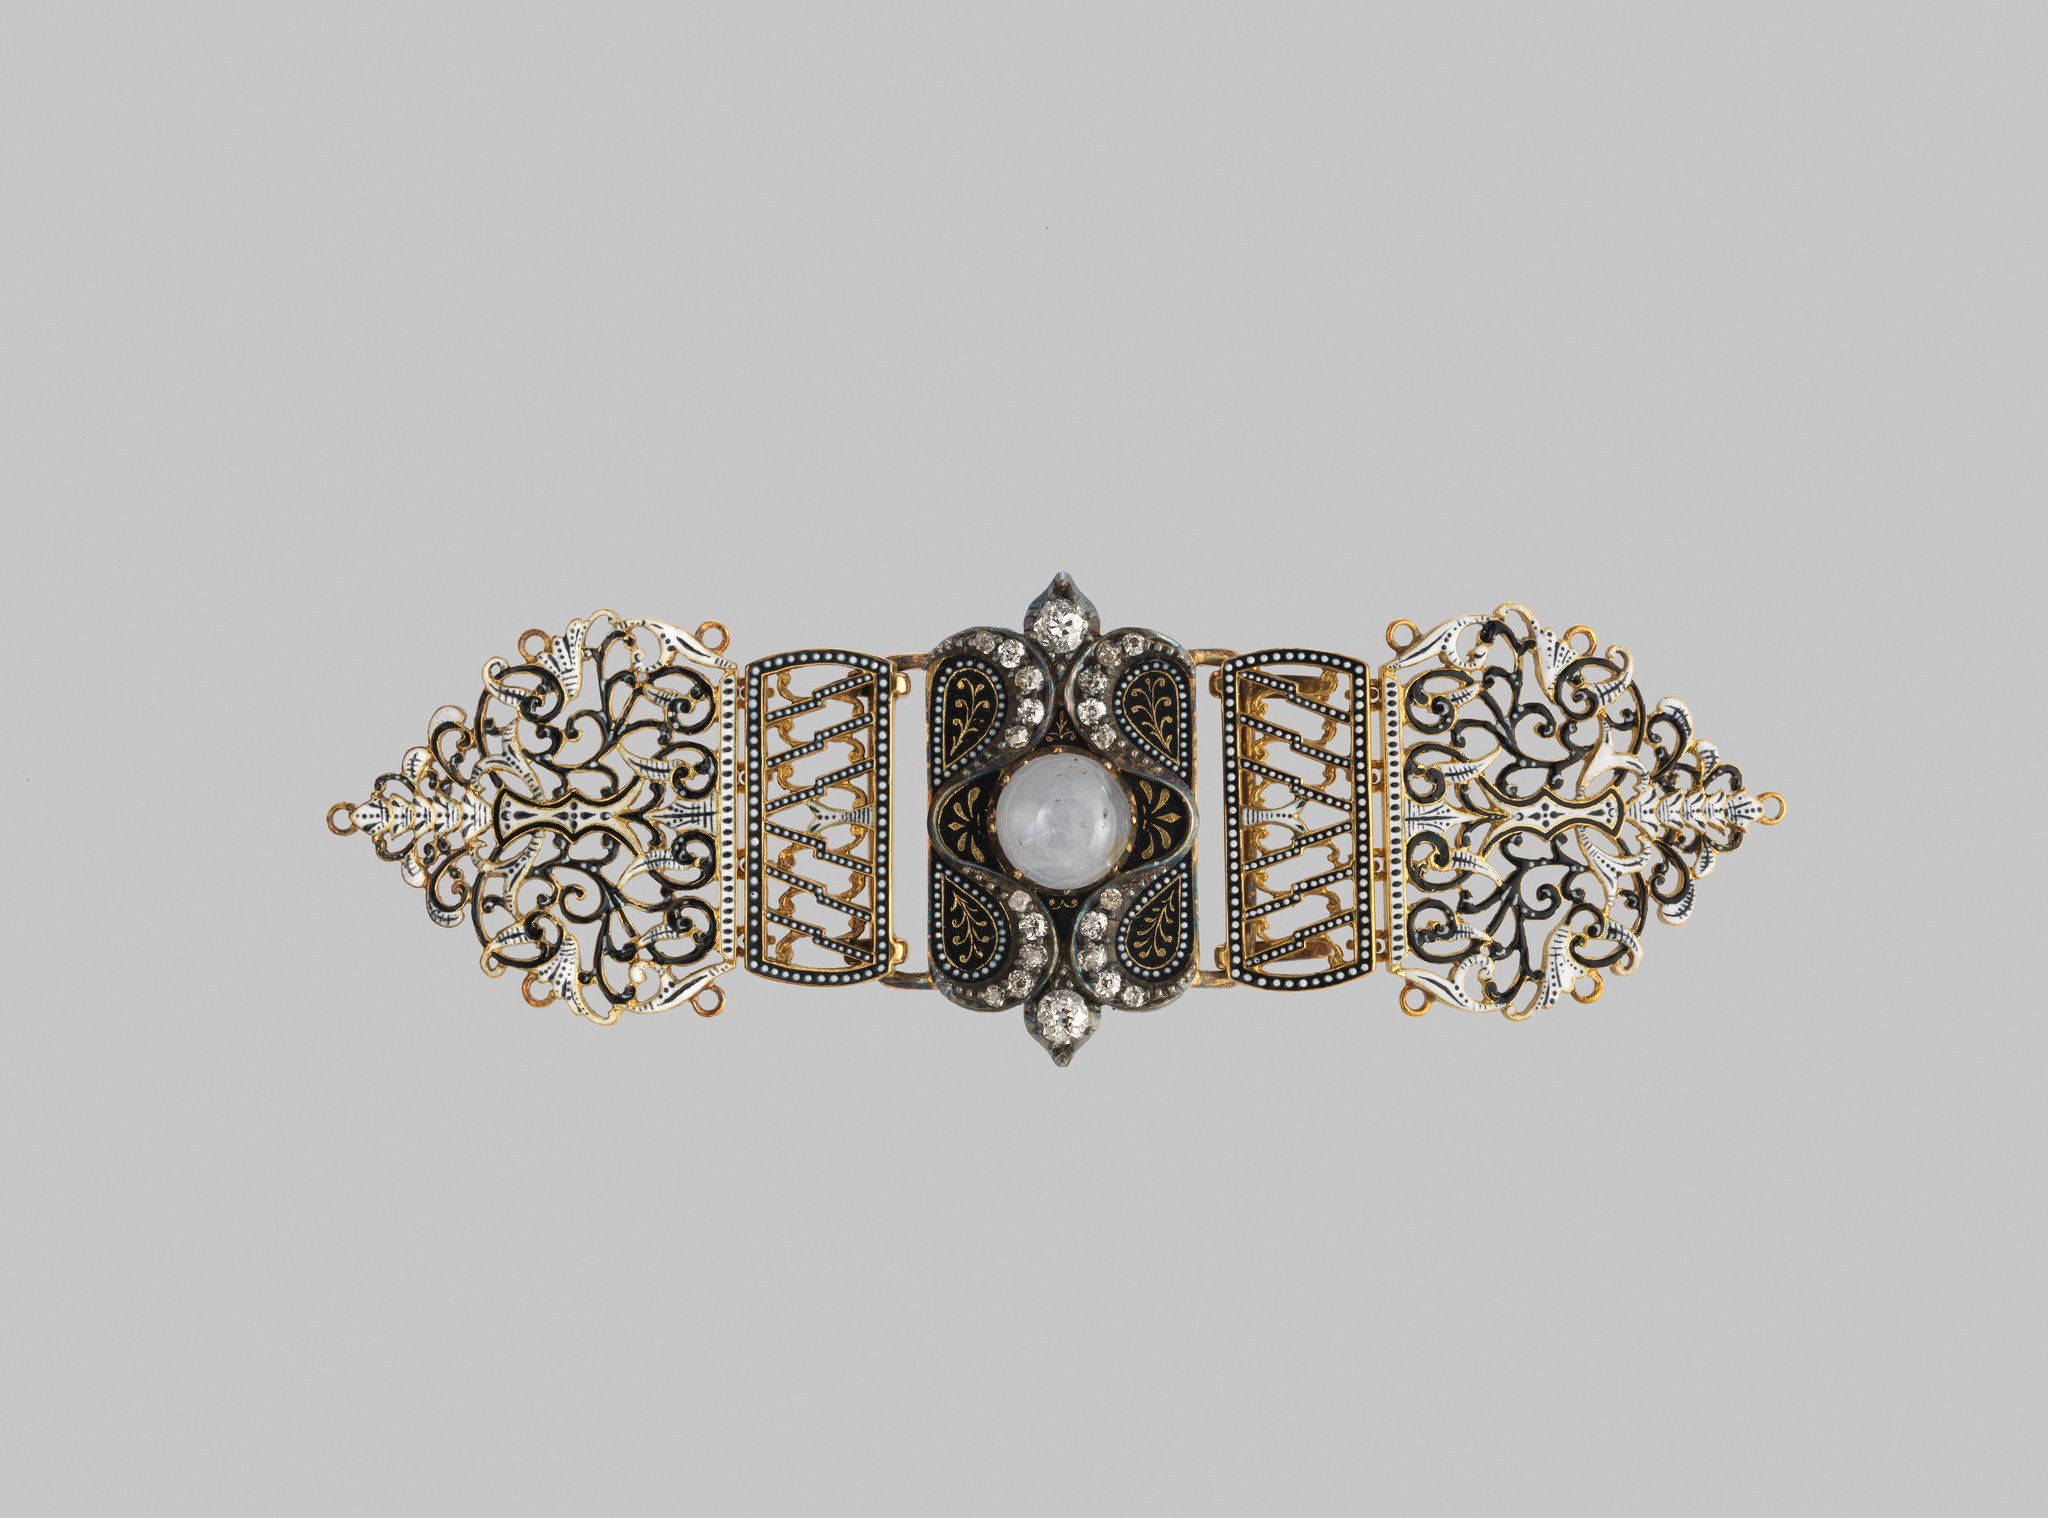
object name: belt buckle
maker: carlo giuliano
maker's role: maker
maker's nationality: italian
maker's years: 1831-1895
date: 1900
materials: diamond, enamel, gold, gemstone, silver